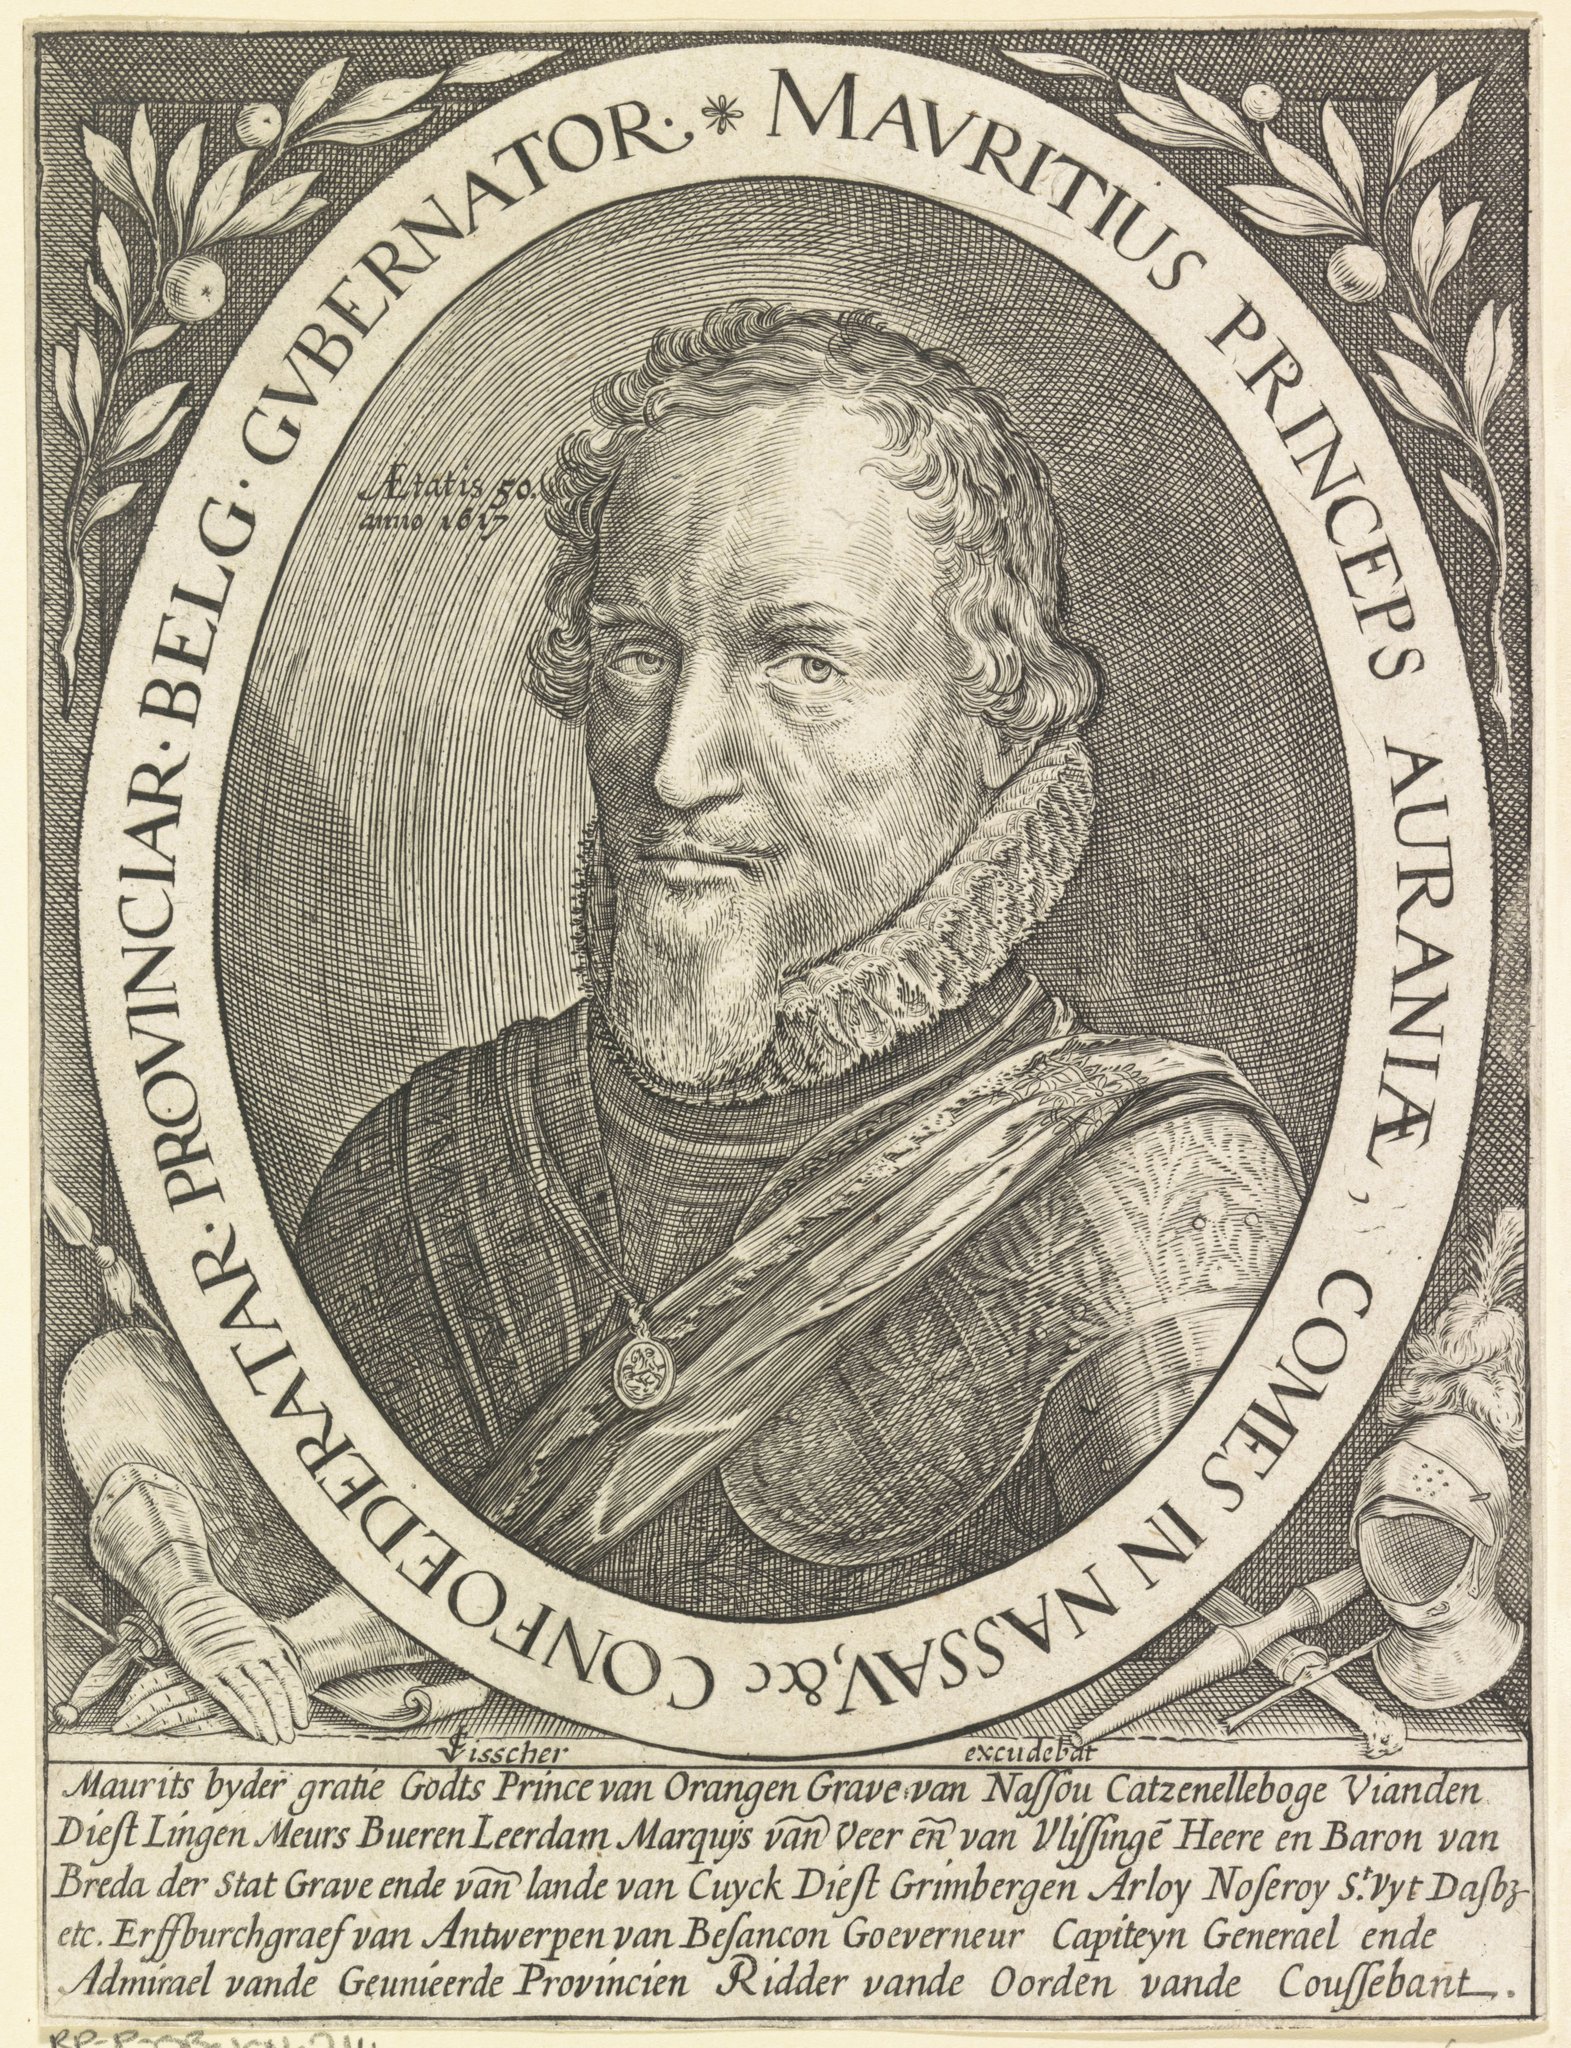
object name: print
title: Portret van Maurits, prins van Oranje, op 50-jarige leeftijd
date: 1617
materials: paper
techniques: engraving, etching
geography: low countries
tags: the hague, maurice (prince of orange), knighthood order (garter) - insignia of a knighthood order, e.g.: badge, chain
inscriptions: collector's mark: Lugt 963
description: De hier vermelde titel verwijst naar de hoogst verkregen titel van de geportretteerde, niet per se naar de titel die de geportretteerde op deze voorstelling draagt.